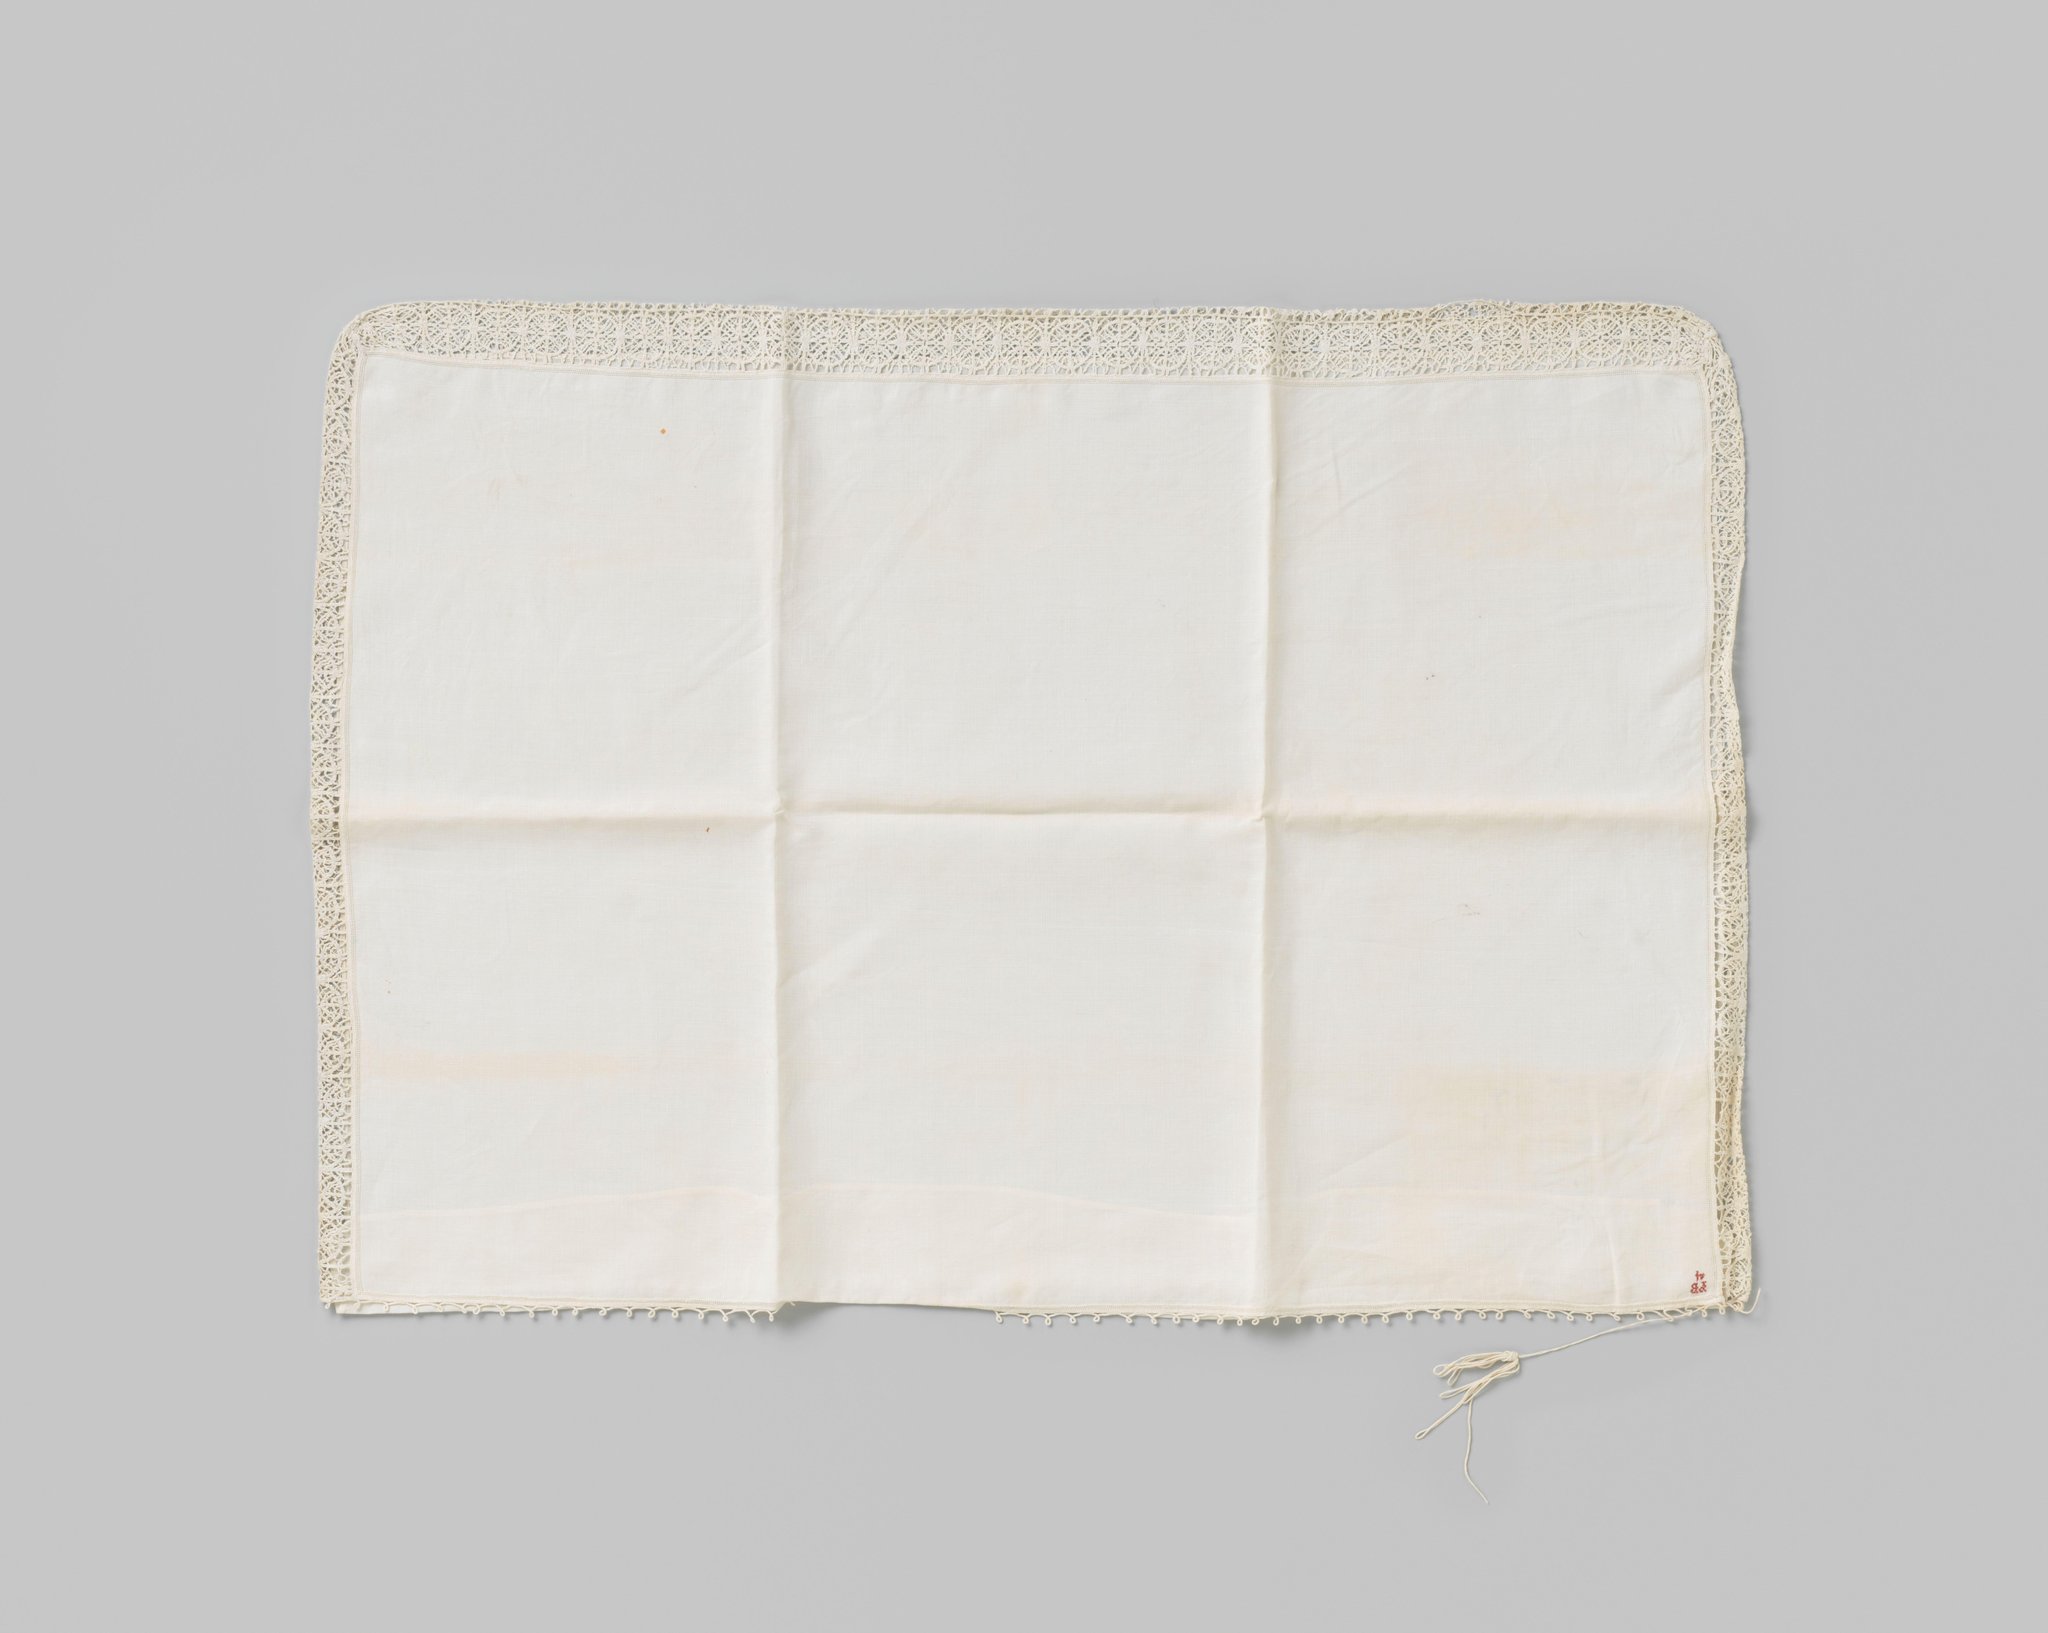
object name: pillowcase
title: Kussensloop van linnen met tussenzetsel van kloskant met koraalvormige voluutranken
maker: Anonymous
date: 1600-1699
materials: linen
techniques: lace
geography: northern netherlands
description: Kussensloop van linnen met aan één korte zijde een tussenzetsel van naturelkleurige kloskant. Het patroon bestaat uit koraalvormige voluutranken, die met elkaar verbonden zijn door een traliegrond, een vijfgaatjesgrond. Bandsluiting.